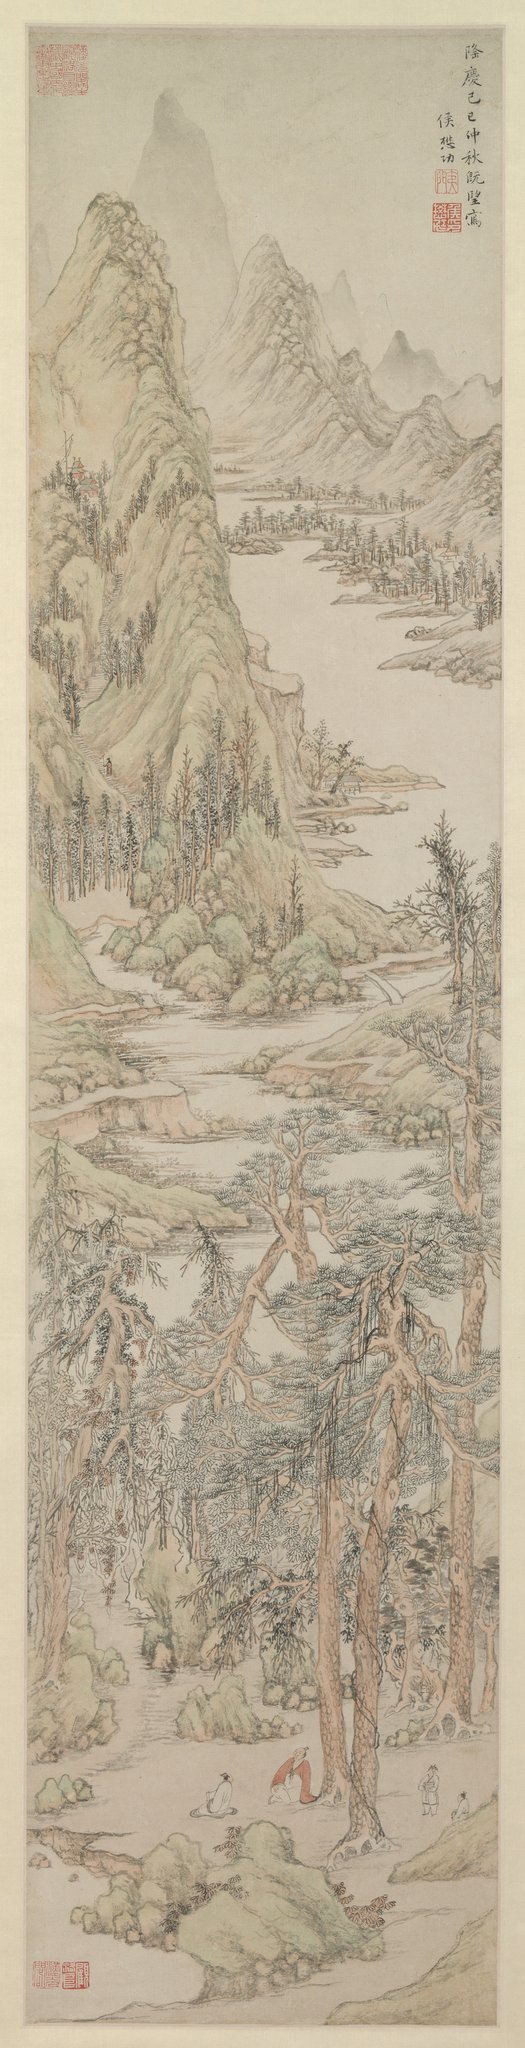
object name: hanging scroll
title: Lofty mountains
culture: chinese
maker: hou maogong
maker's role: artist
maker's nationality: chinese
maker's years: 1540-1580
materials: ink, paper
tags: mountains,landscapes